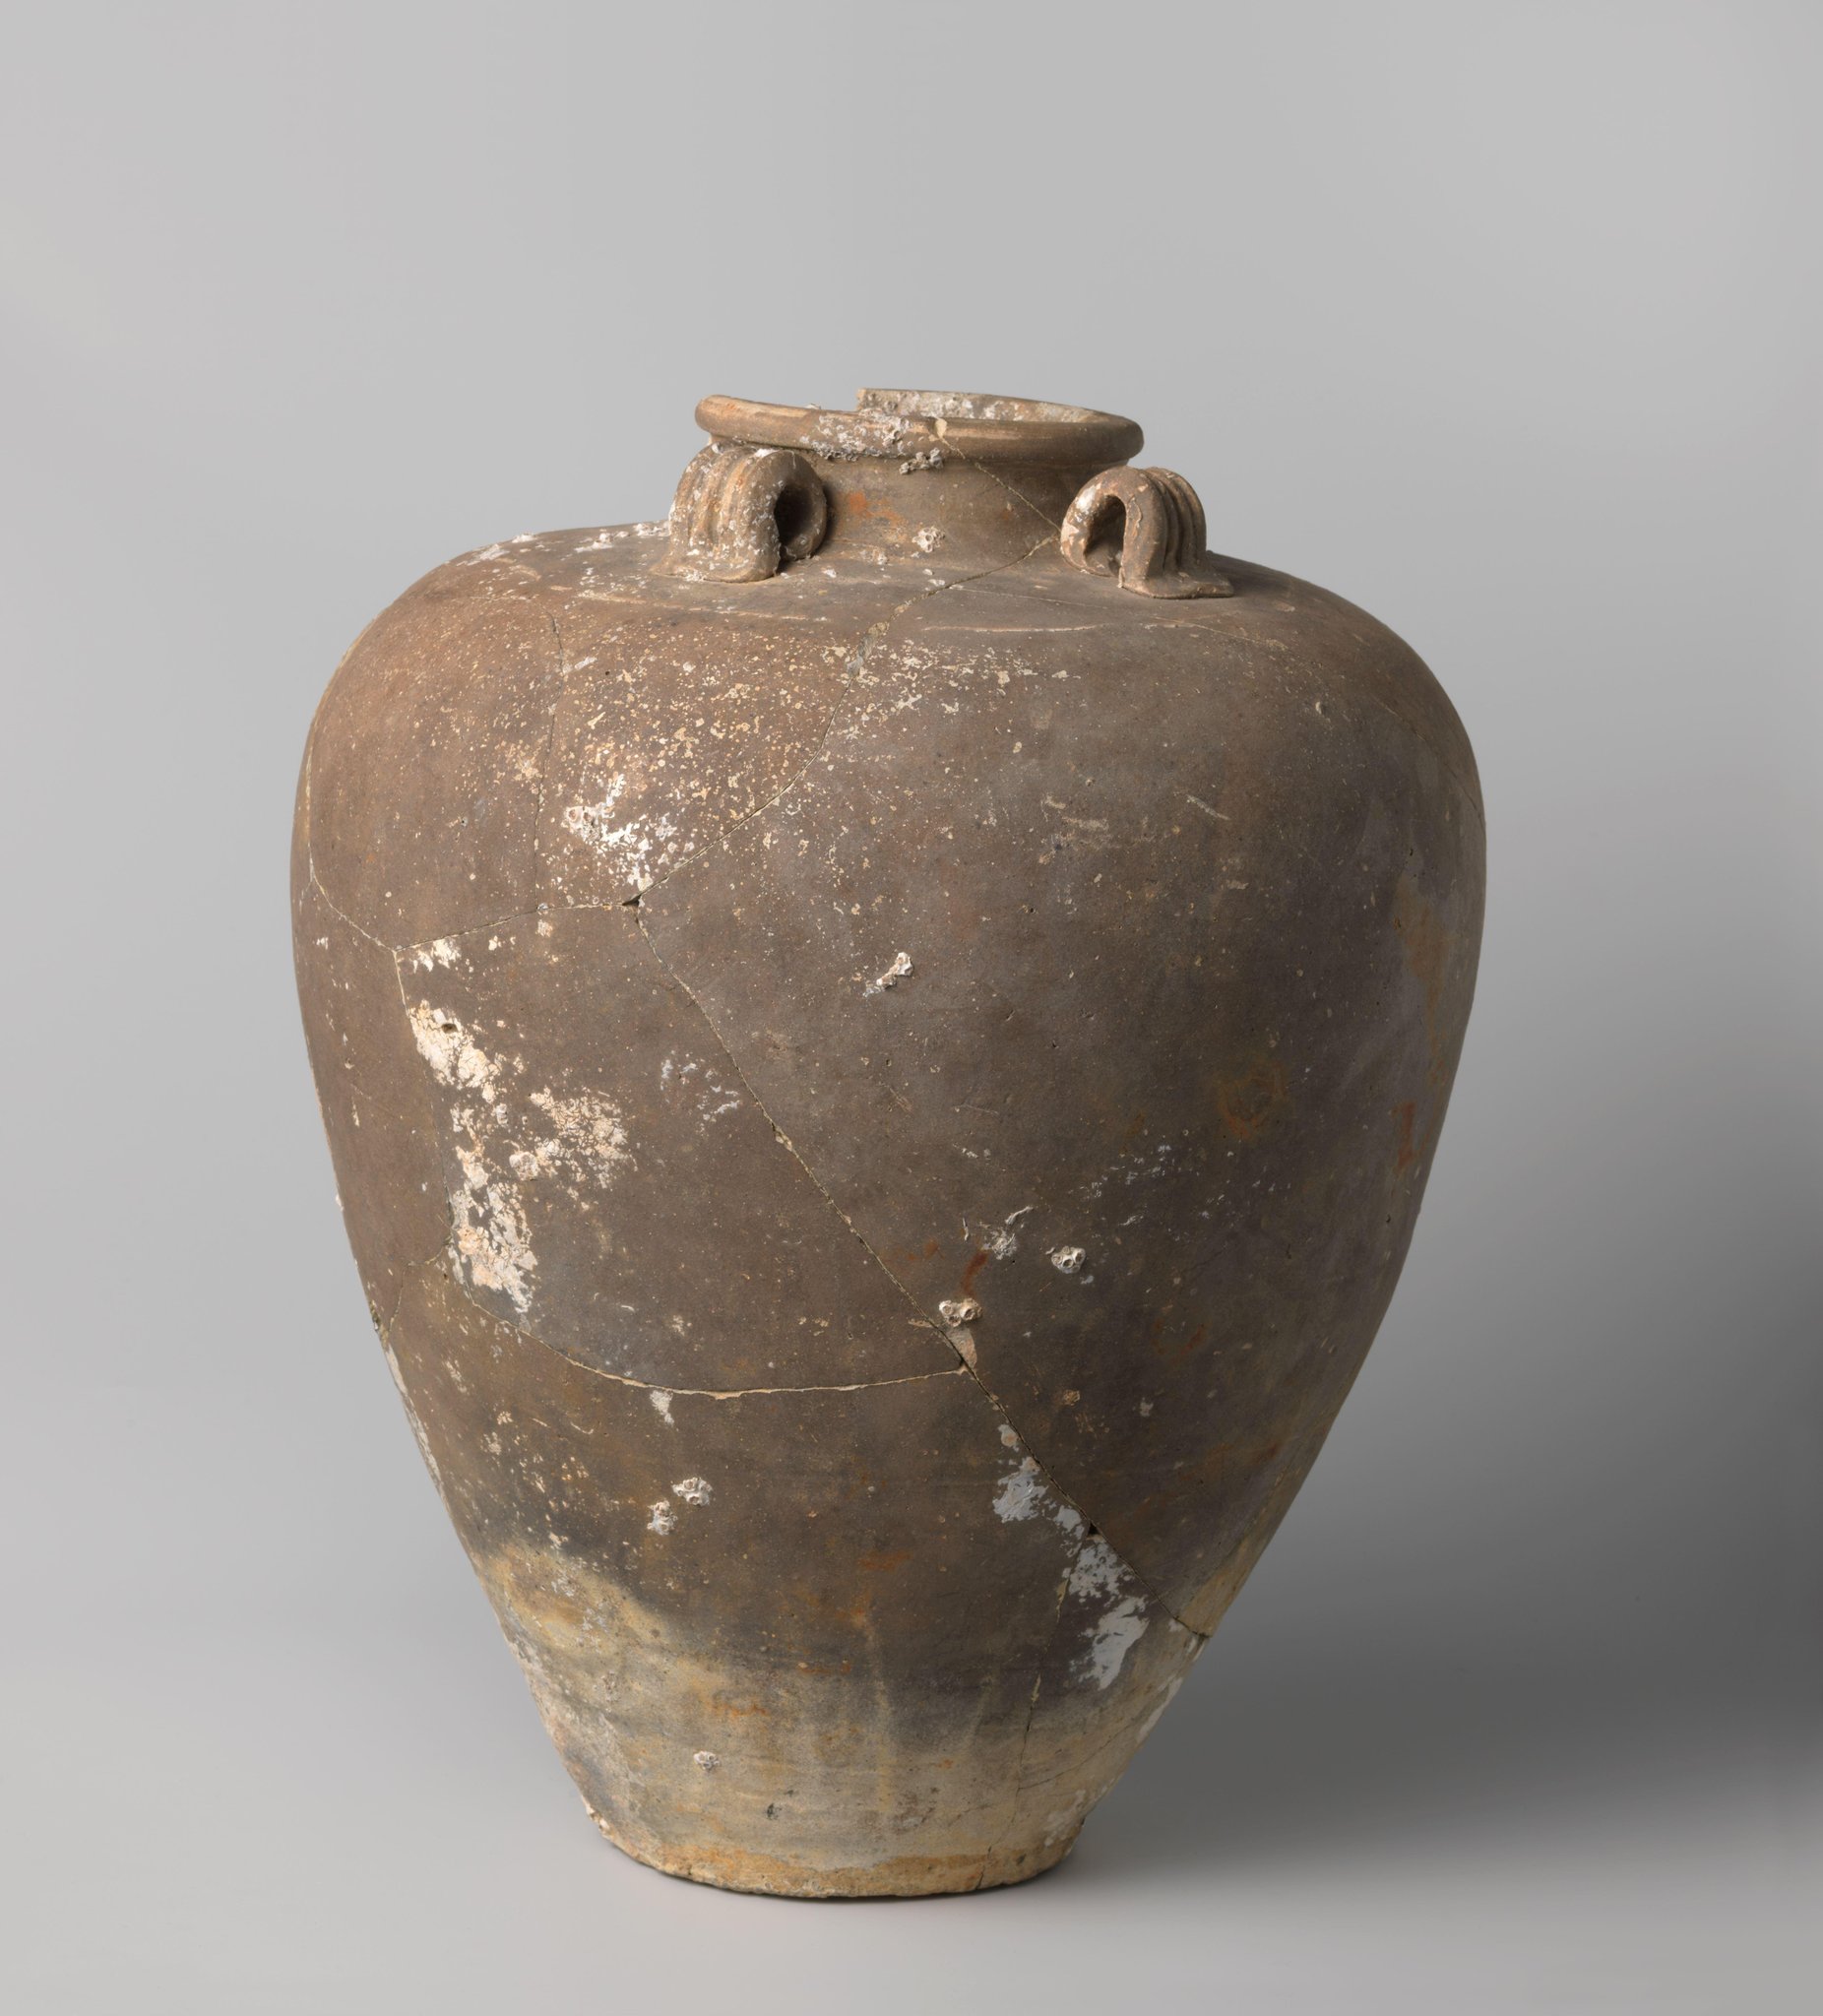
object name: martavaan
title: Martavaan uit V.O.C.-schip de 'Witte Leeuw'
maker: Anonymous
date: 1613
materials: porcelain, stoneware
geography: southeast asia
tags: verenigde oostindische compagnie, sint-helena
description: A jar. The interior and exterior is covered by a dark grey and reddish glaze. The base and lower part of the waist is unglazed and has a yellow surface. There is a grey-yellow band on the shoulder, a few centimeters beneath the ears, where the glaze has come off due to another jar having been placed over this one during firing process.